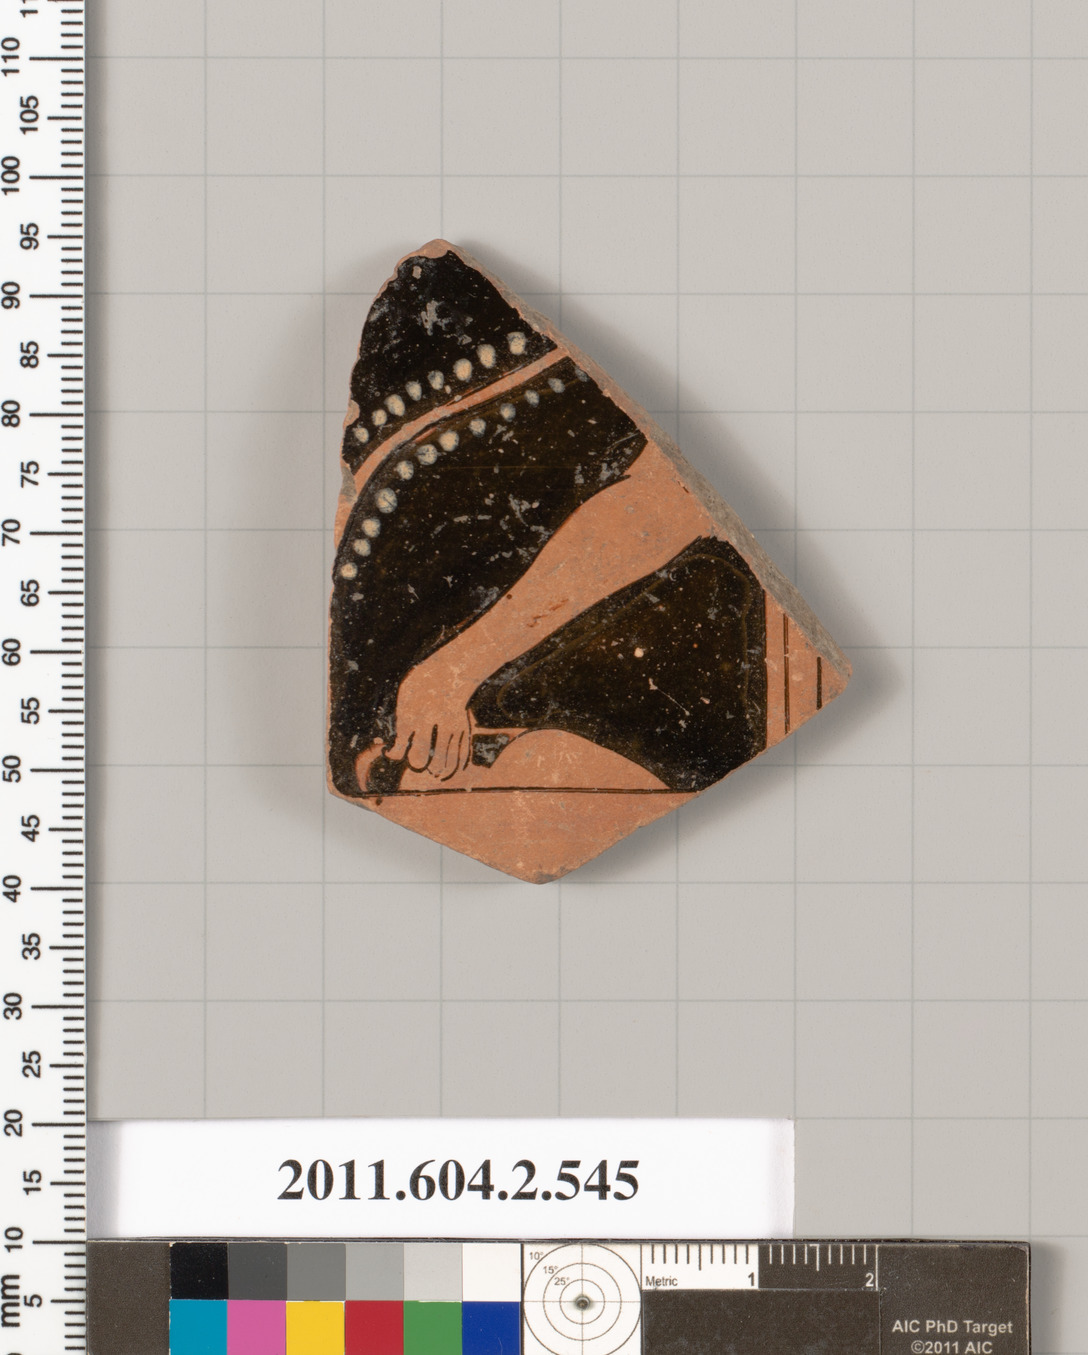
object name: column krater fragment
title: Terracotta fragment of a column-krater (bowl for mixing wine and water)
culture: greek, attic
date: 460-450 BCE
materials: terracotta